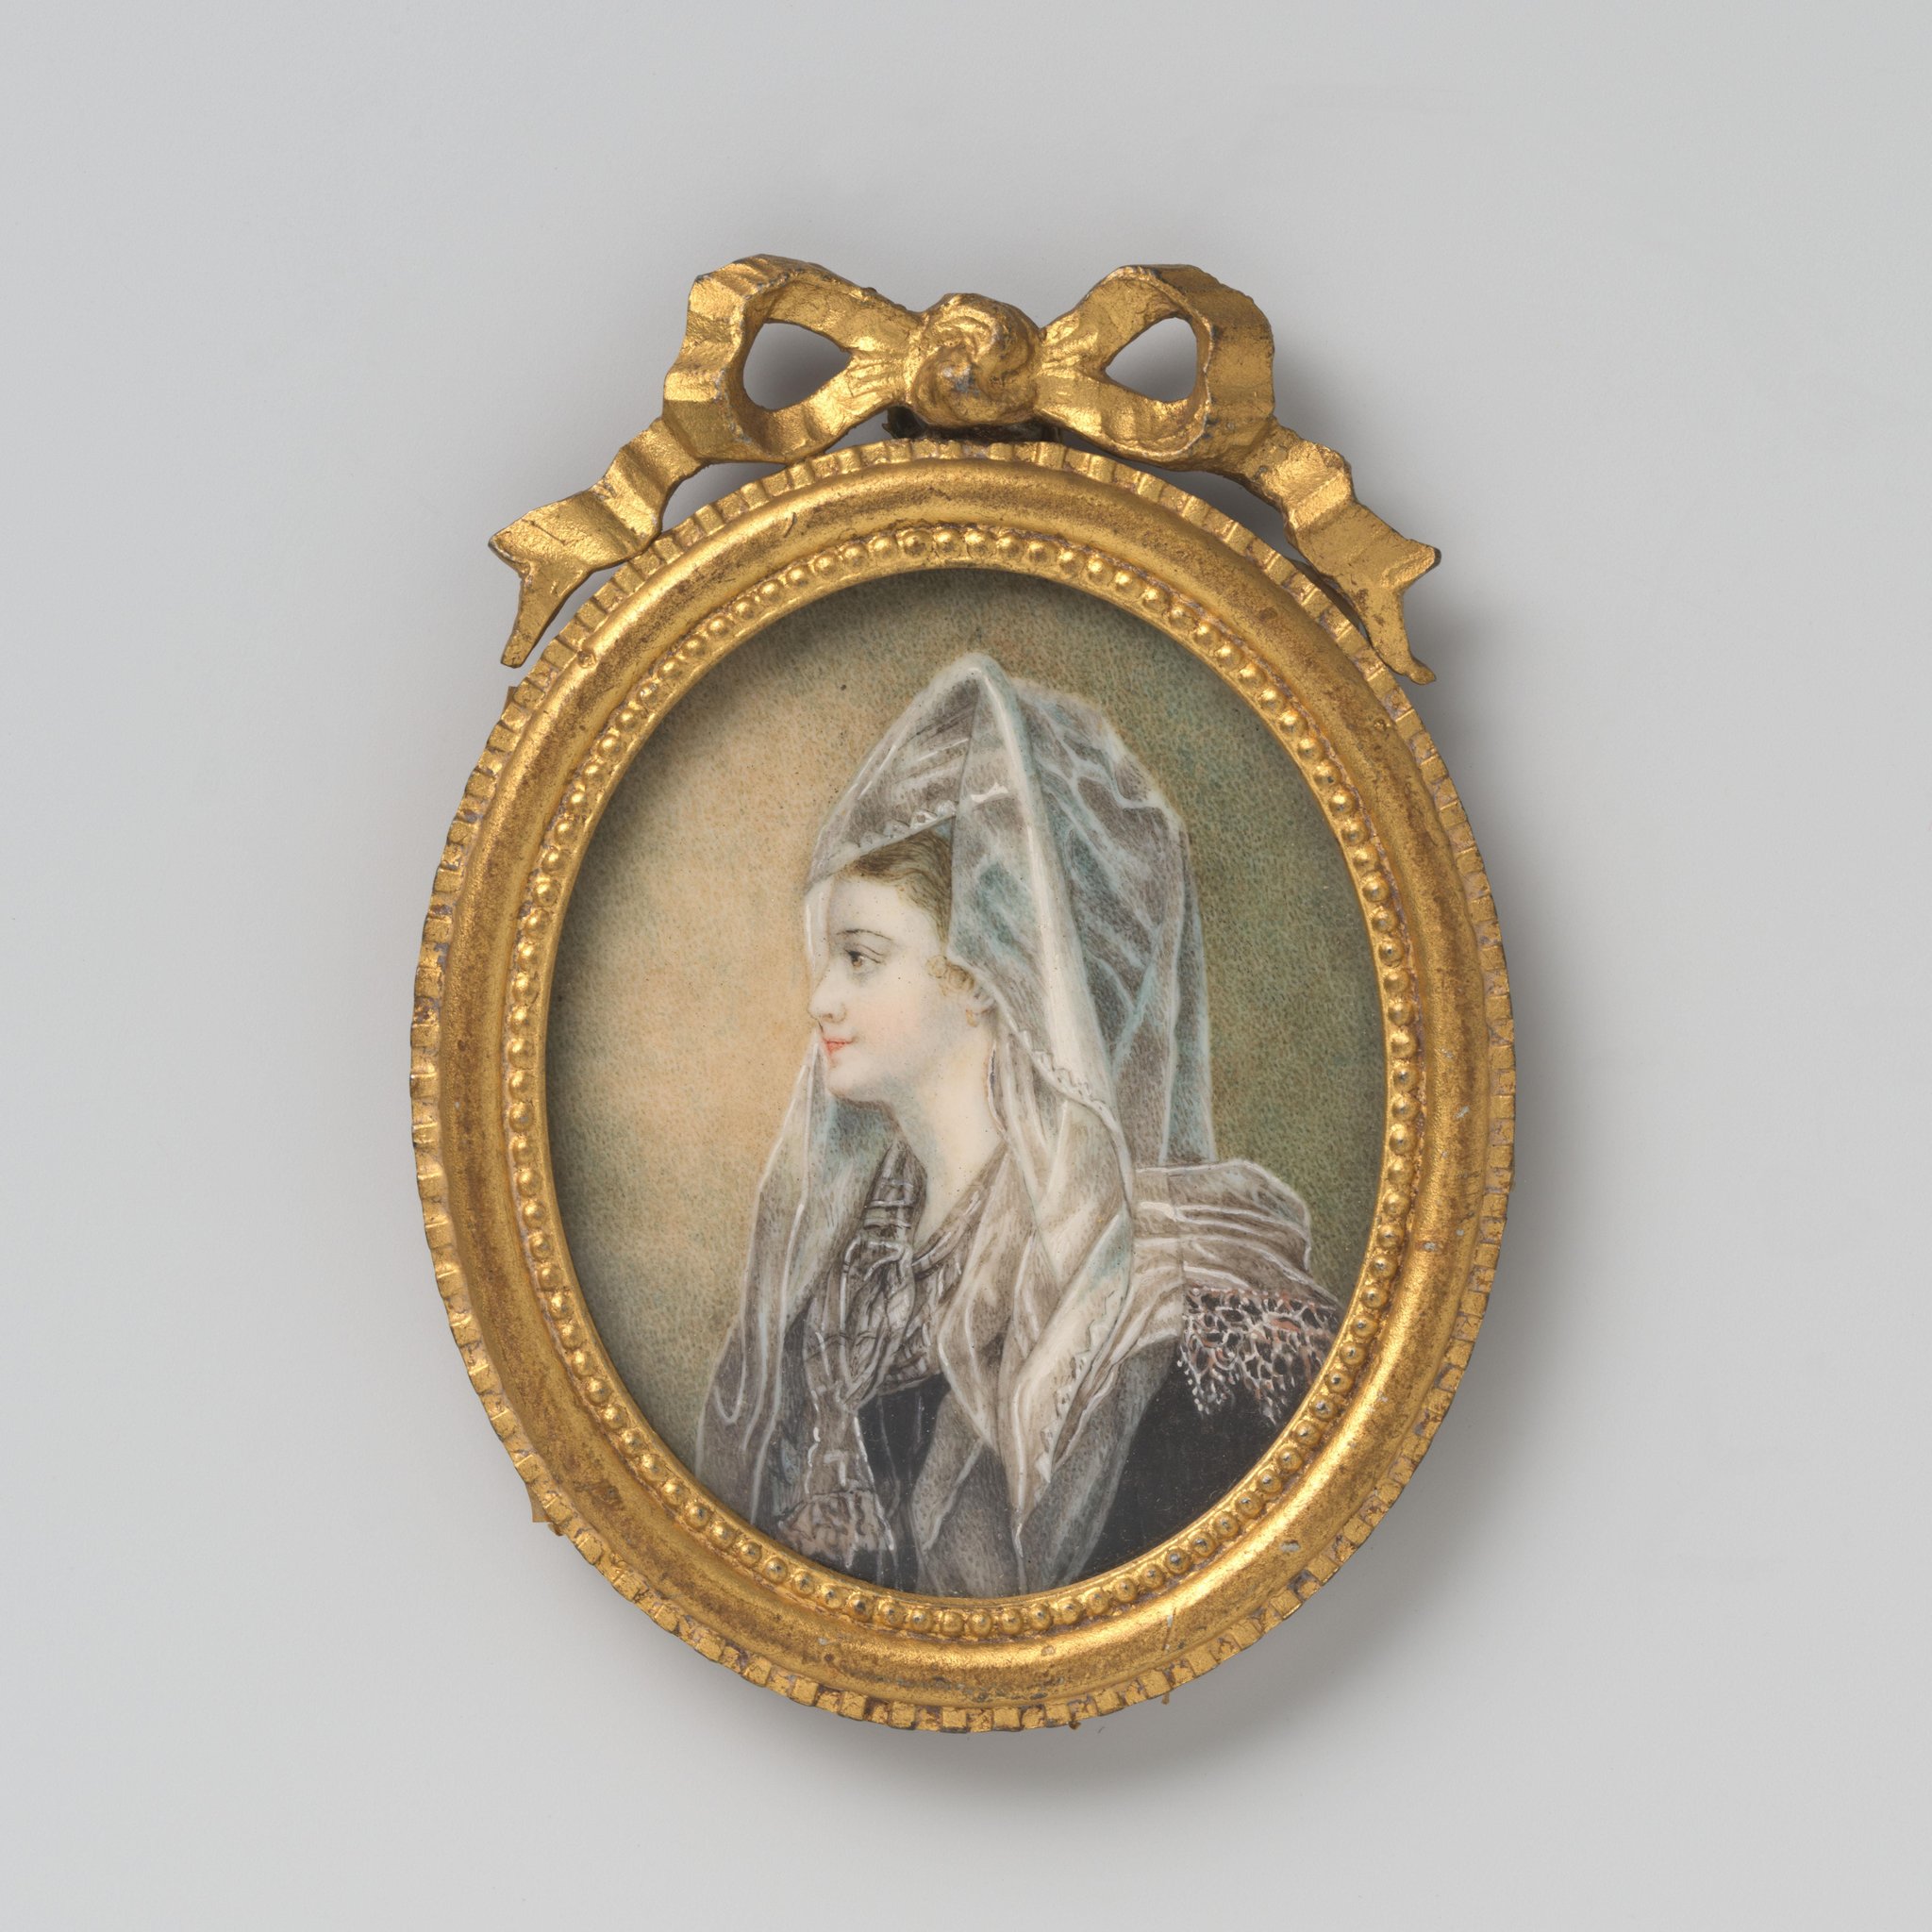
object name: miniature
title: Schilderij met voorstelling van een vrouw met opgeheven rechterarm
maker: Anonymous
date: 1850-1899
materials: alloy, glass, gold, gouache, ivory, lead, paper, tin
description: Schilderij met voorstelling van een vrouw met opgeheven rechterarm. De vrouw is ten halven lijve afgebeeld, gekleed in 18de-eeuwse dracht, bestaande uit een groene jurk met witte battisten omslagdoek en manchetten en bloemcorsage op de borst. Haar grijsblonde haren opgestoken met lint. Gevat in een ovale lijst van metaal in neo-klassicistische stijl met parel- en ribbelrand, bekroond door strik.